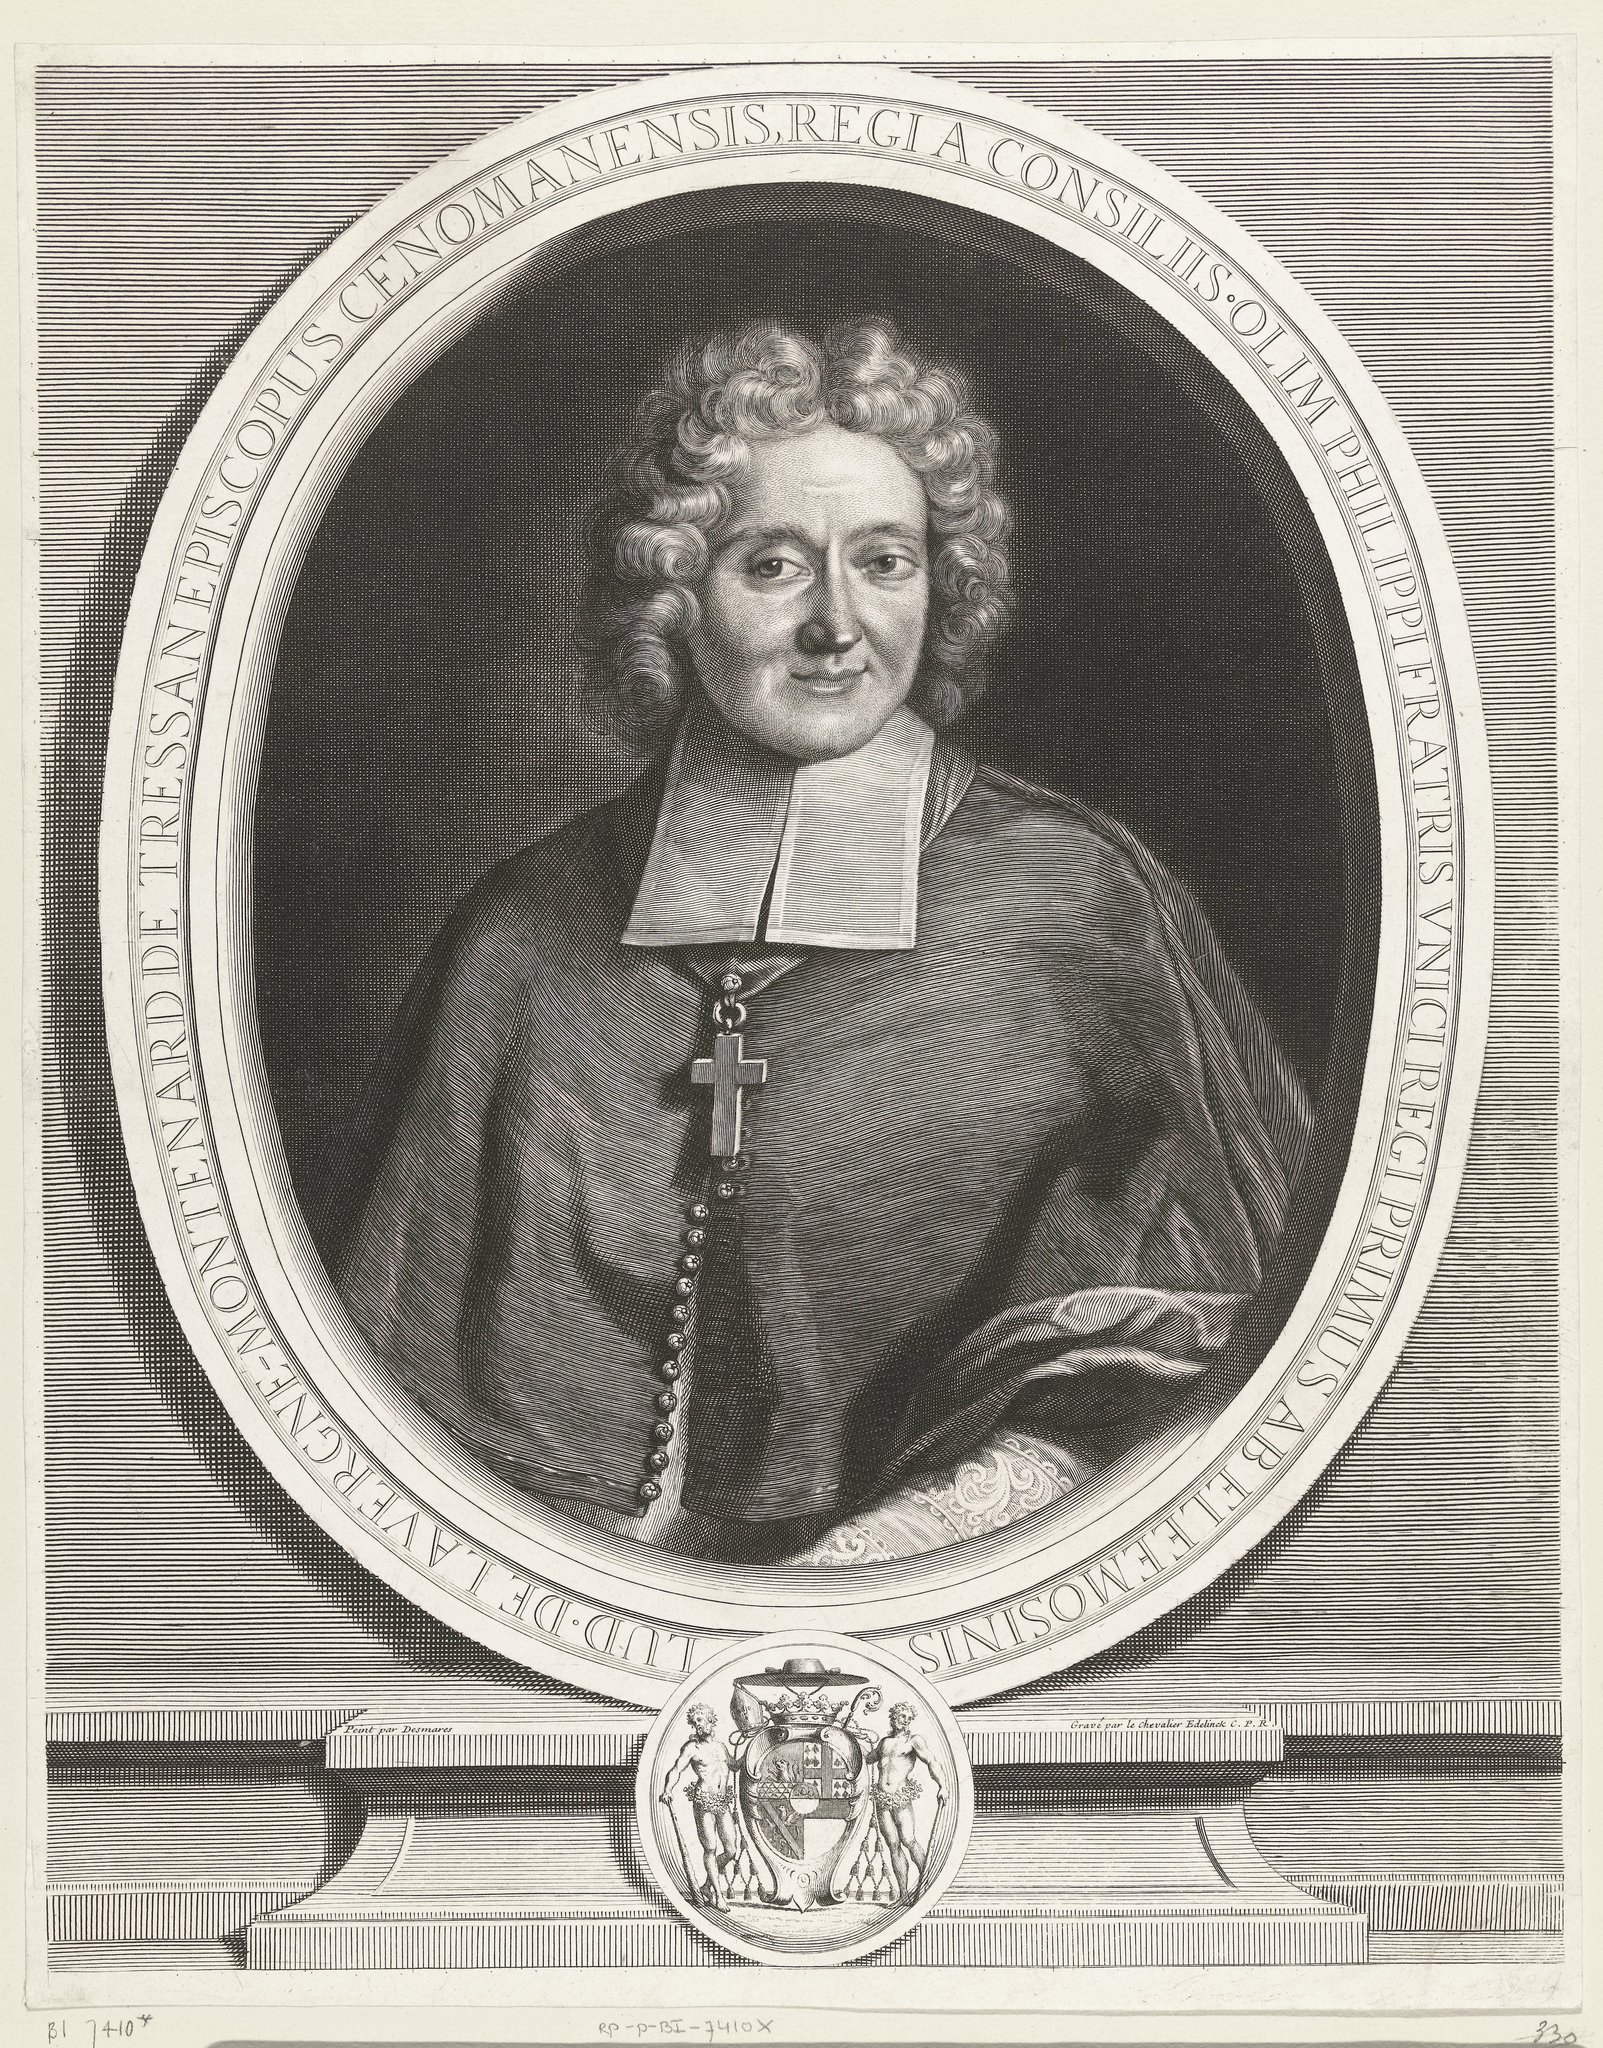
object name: print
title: Portret van Louis de La Vergne-Montenard de Tressan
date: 1666-1707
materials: paper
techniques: engraving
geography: paris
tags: aartsbisschop, louis de la vergne-montenard de tressan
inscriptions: collector's mark: Lugt 240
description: Portret van de Franse aartsbisschop Louis de La Vergne-Montenard de Tressan (1670-1733), afgebeeld in ovale omlijsting met tekst in Latijn en wapen.